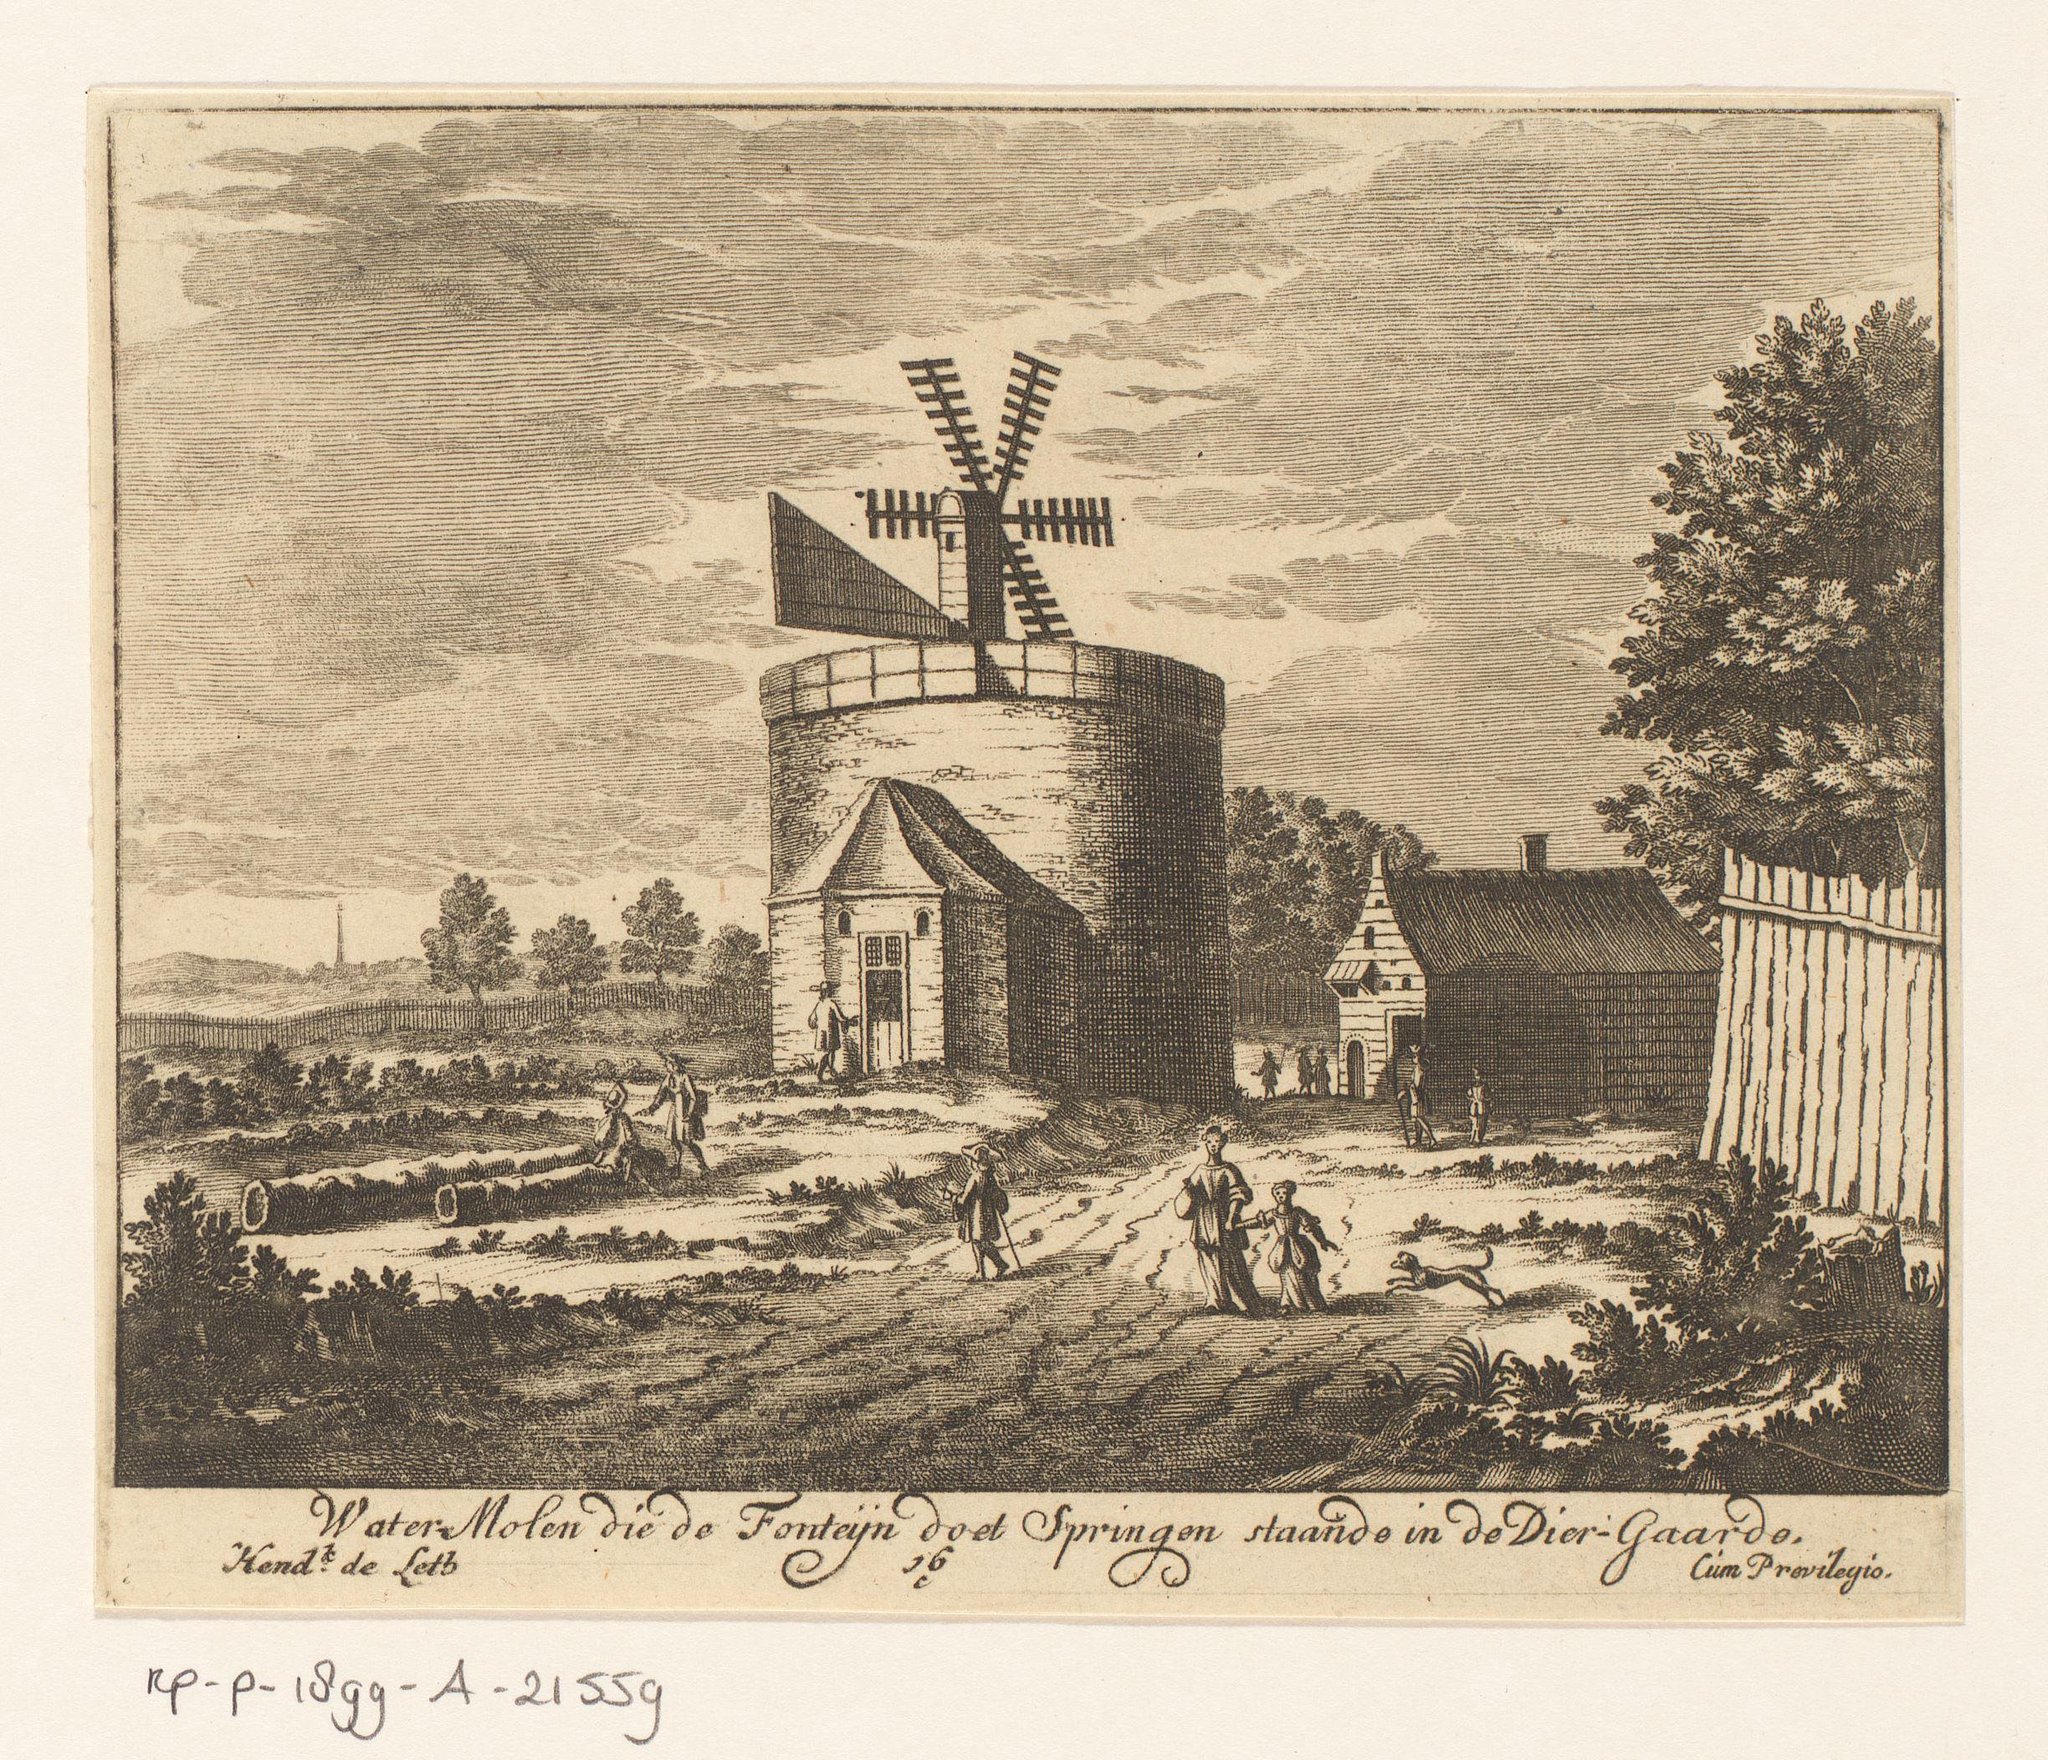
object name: print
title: Watermolen op het landgoed van Paleis Soestdijk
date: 1725-1747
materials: paper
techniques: etching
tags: watermill in landscape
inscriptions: collector's mark: Lugt 2228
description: De watermolen op het landgoed van Paleis Soestdijk, op de voorgrond wandelen figuren. De prent maakt deel uit van een serie met zestien gezichten op Paleis Soestdijk en het bijbehorende landgoed.